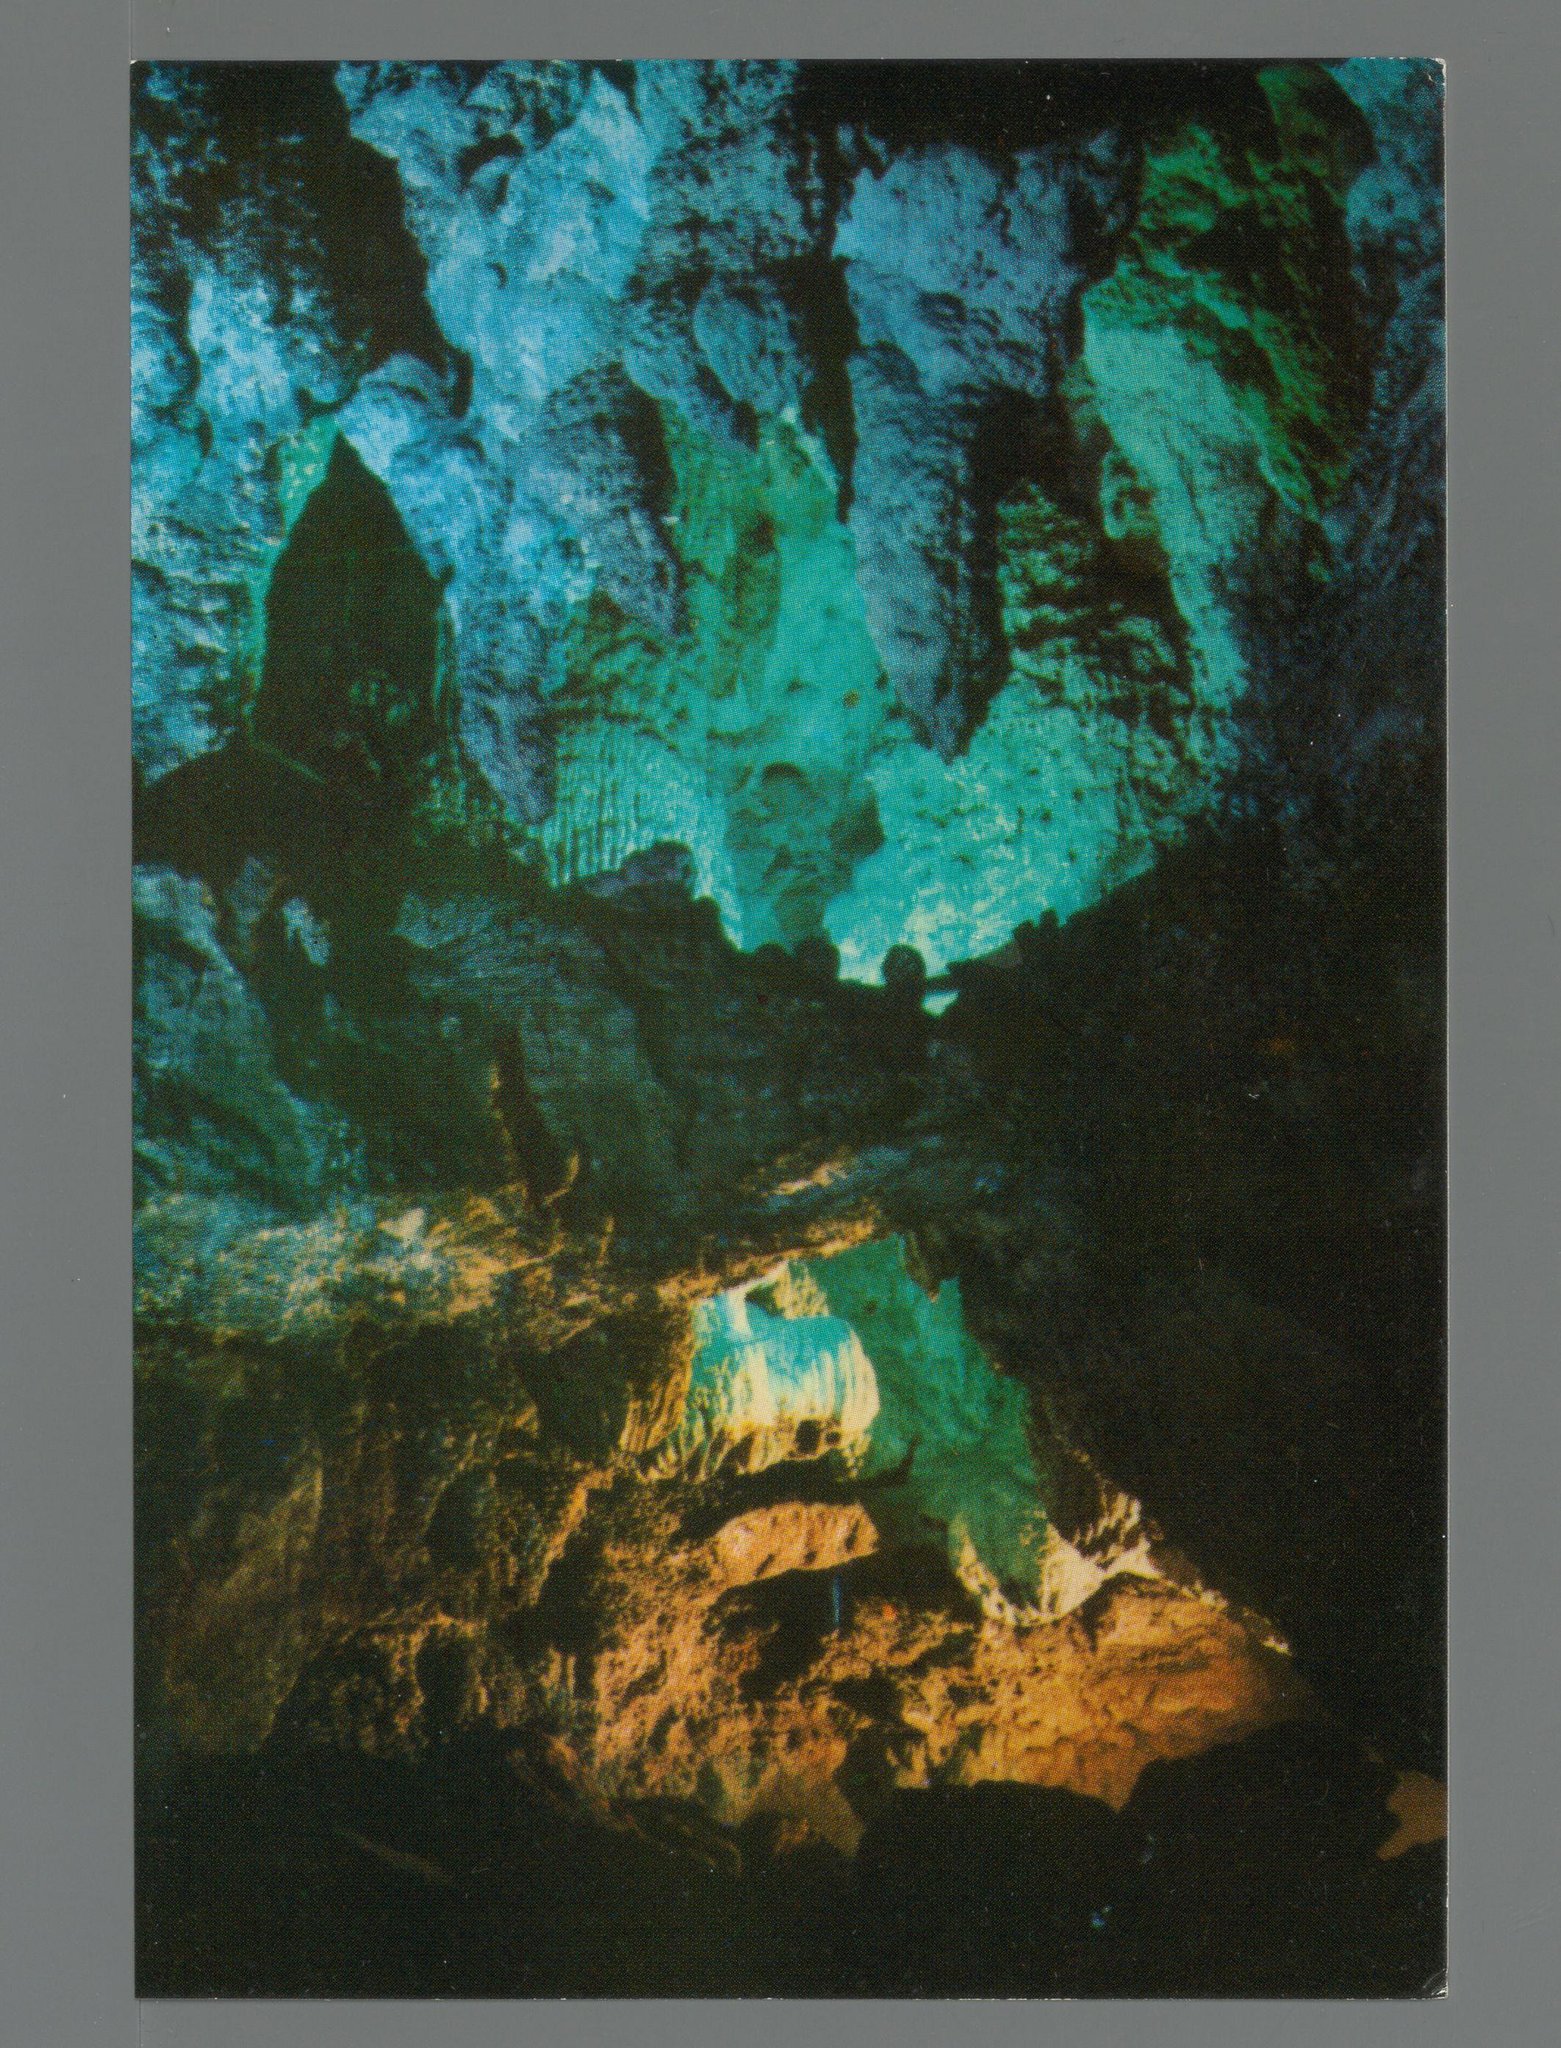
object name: photomechanical print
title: Dripstones in Seven Star Cavern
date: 1974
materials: cardboard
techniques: offset printed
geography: beijing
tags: stalactitic cave